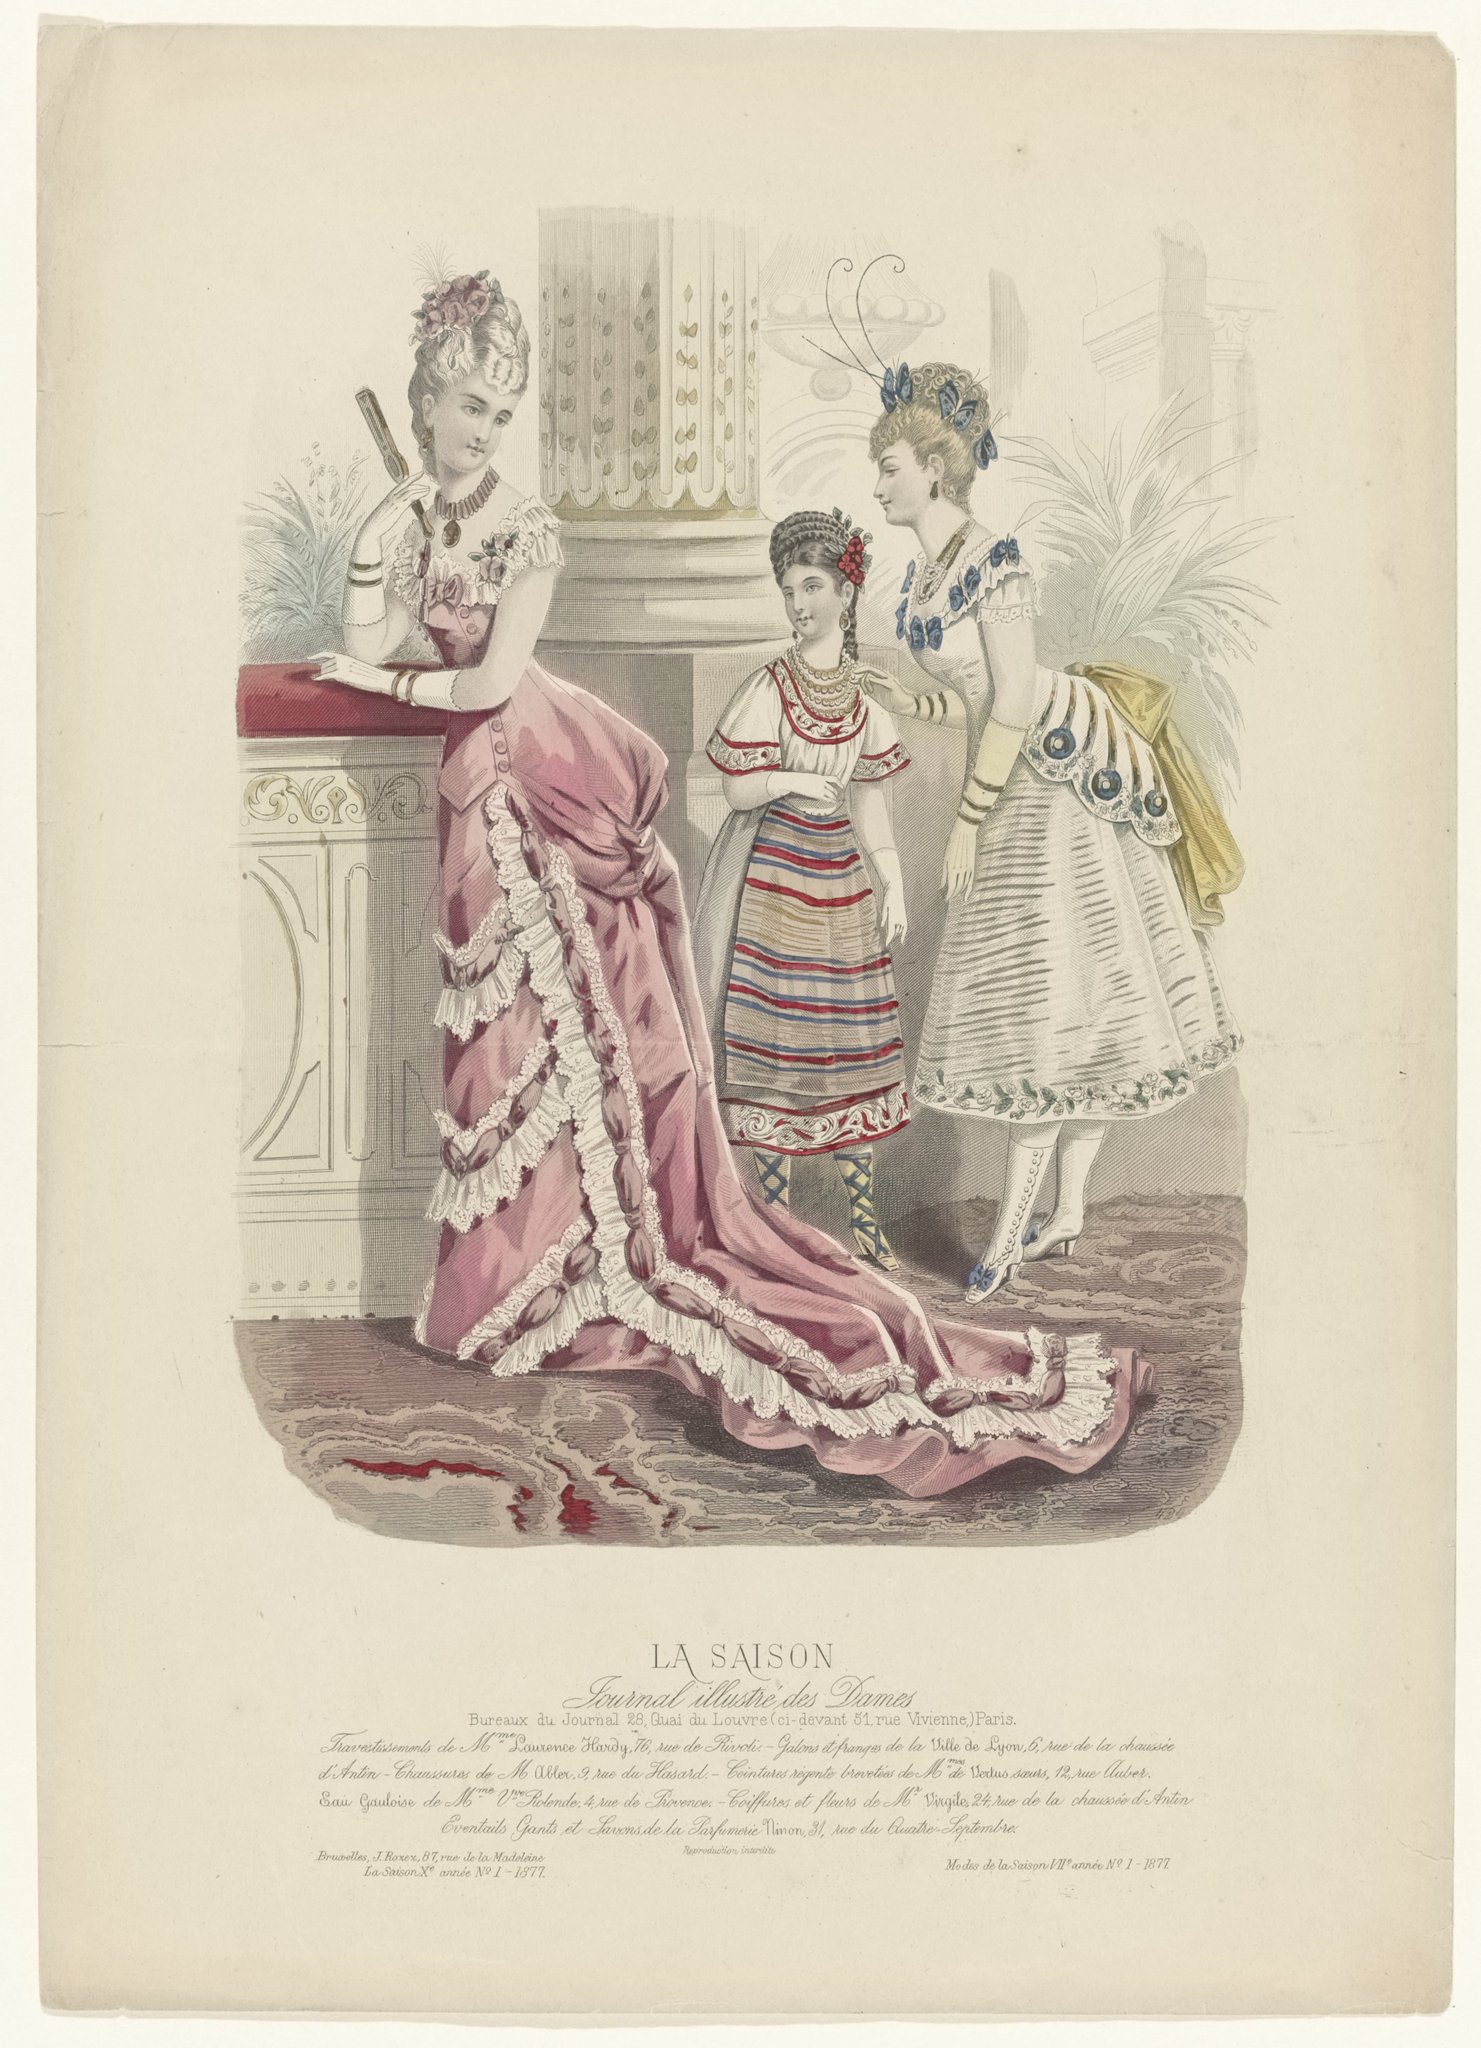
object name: fashion print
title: La Saison, Journal illustré des Dames, 1877, 10e année, No. 1, No. 424: Travestissements de Mme Laurence Hardy (...)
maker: Anonymous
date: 1877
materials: paper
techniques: engraving, hand coloring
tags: dress-up party (+ women's clothes), dress-up party (+ girls' clothes), gloves, mittens (long gloves) (+ destination or function of clothes), fashion plates, fan (+ women's clothes)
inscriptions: caption: ‘Travestissements de Mme Laurence Hardy, 76, rue de Rivoli .- Galons et franges de la Ville de Lyon, 6, rue de la chaussée d'Antin - Chaussures de M Abler, 9, rue du Hasard. - Ceintures régente brevetées de Mmes de Vertus soeurs, 12, rue Auber. Eau Gauloise de Mme Vve Rolend, 4, rue de Provence. - Coiffures et fleurs de Mr Virgile, 24, rue de la chaussée d'Antin Eventails Gants et Savons de la Parfumerie Ninon, 31, rue du Quatre-Septembre.’, inscription: ‘Bruxelles, J. Rozez, 87, rue de la Madeleine. La Saison Xe année No 1 - 1877 / Modes de la Saison VIIe année No 1 - 1877’, address: ‘Bureaux du Journal, 28, Quai du Louvre (ci-devant 51, rue Vivienne), Paris.’, title: ‘LA SAISON / Journal illustré des Dames’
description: Vrouw en twee meisjes in verkleedkleren. Volgens het onderschrift: 'travestissements' van Laurence Hardy. Hieronder enkele regels reclametekst voor verschillende producten. Prent uit de modetijdschriften(?) La Saison (1867-1902) en Les Modes de la Saison (1871-1885).